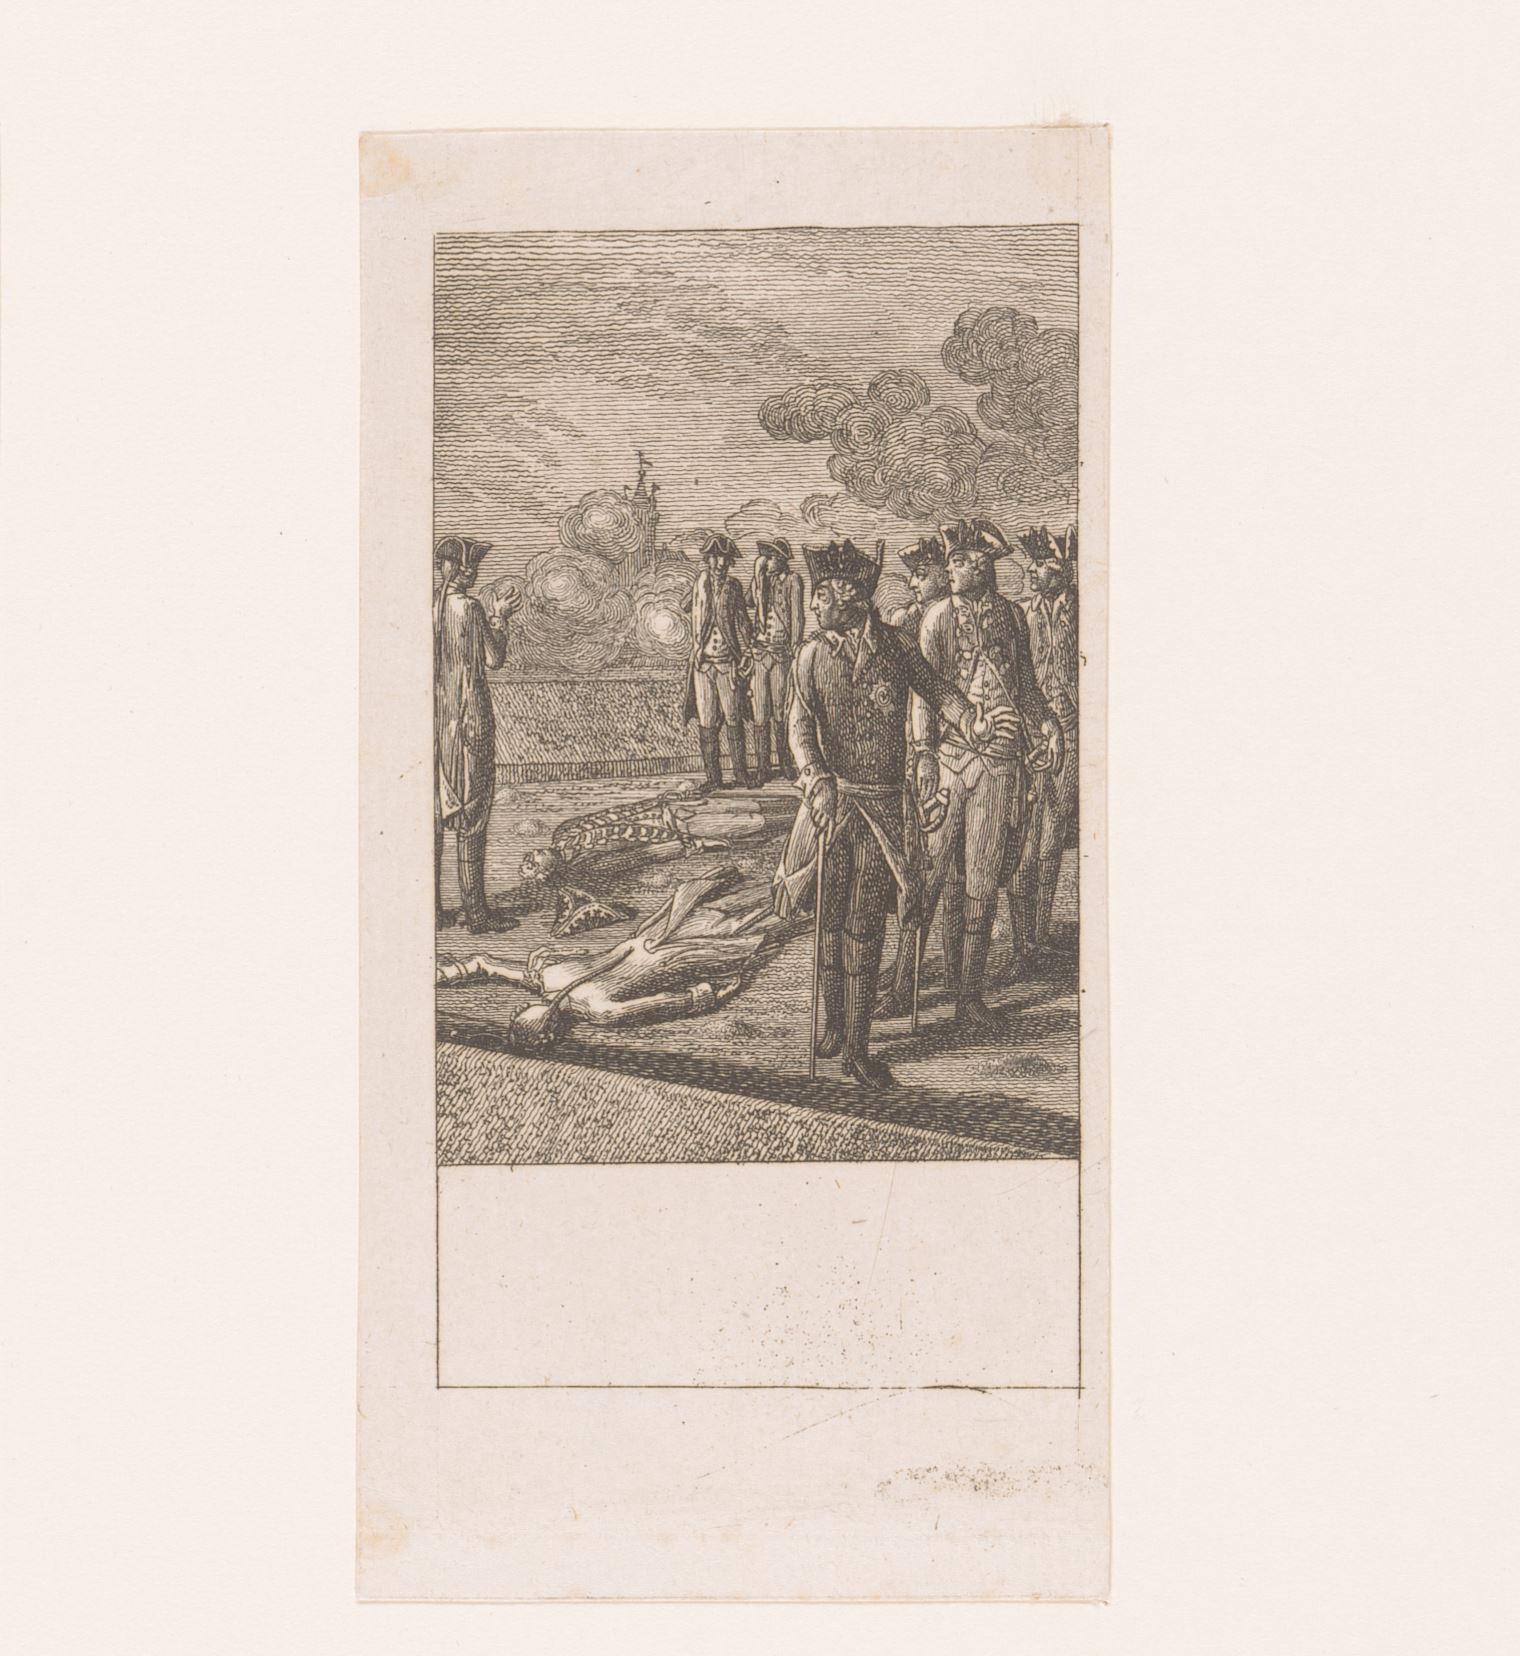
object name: print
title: Soldaten inspecteren twee dode soldaten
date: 1750-1849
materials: paper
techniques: etching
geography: germany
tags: the soldier; the soldier's life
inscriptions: collector's mark: Lugt 2228